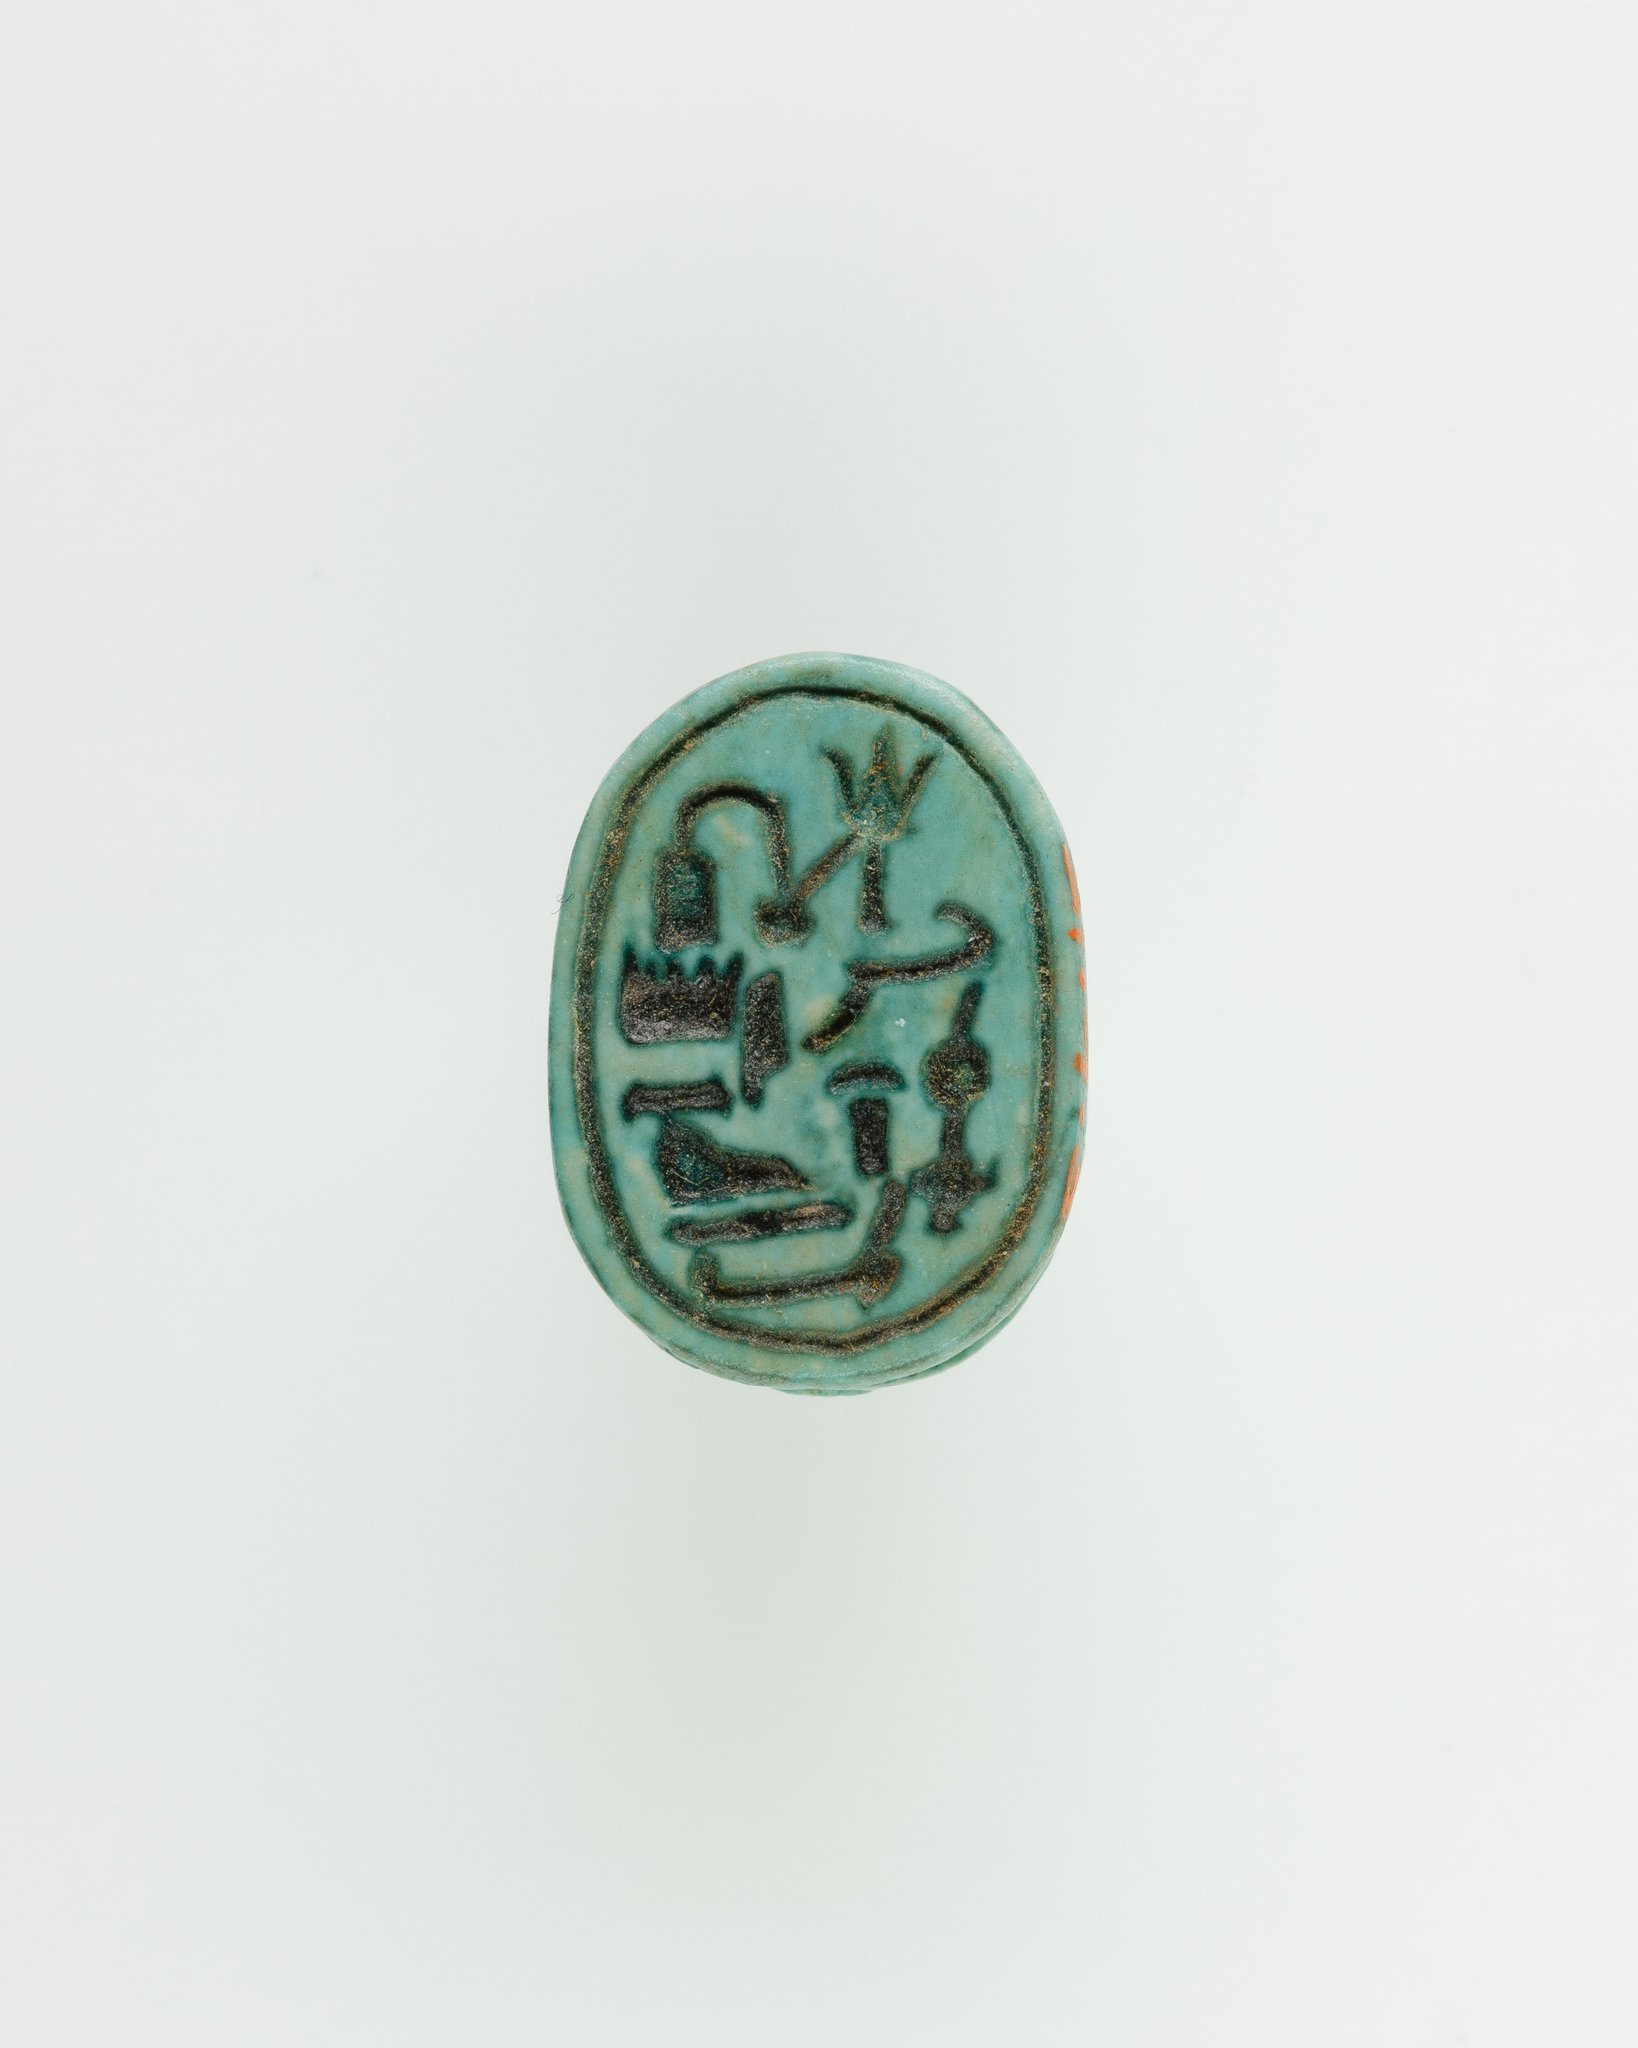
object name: scarab, qenamun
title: Scarab with the Name of the Overseer of Craftsmen and Carpenters, Qenamun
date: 1479-1458 BCE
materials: stone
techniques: glazing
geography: egypt